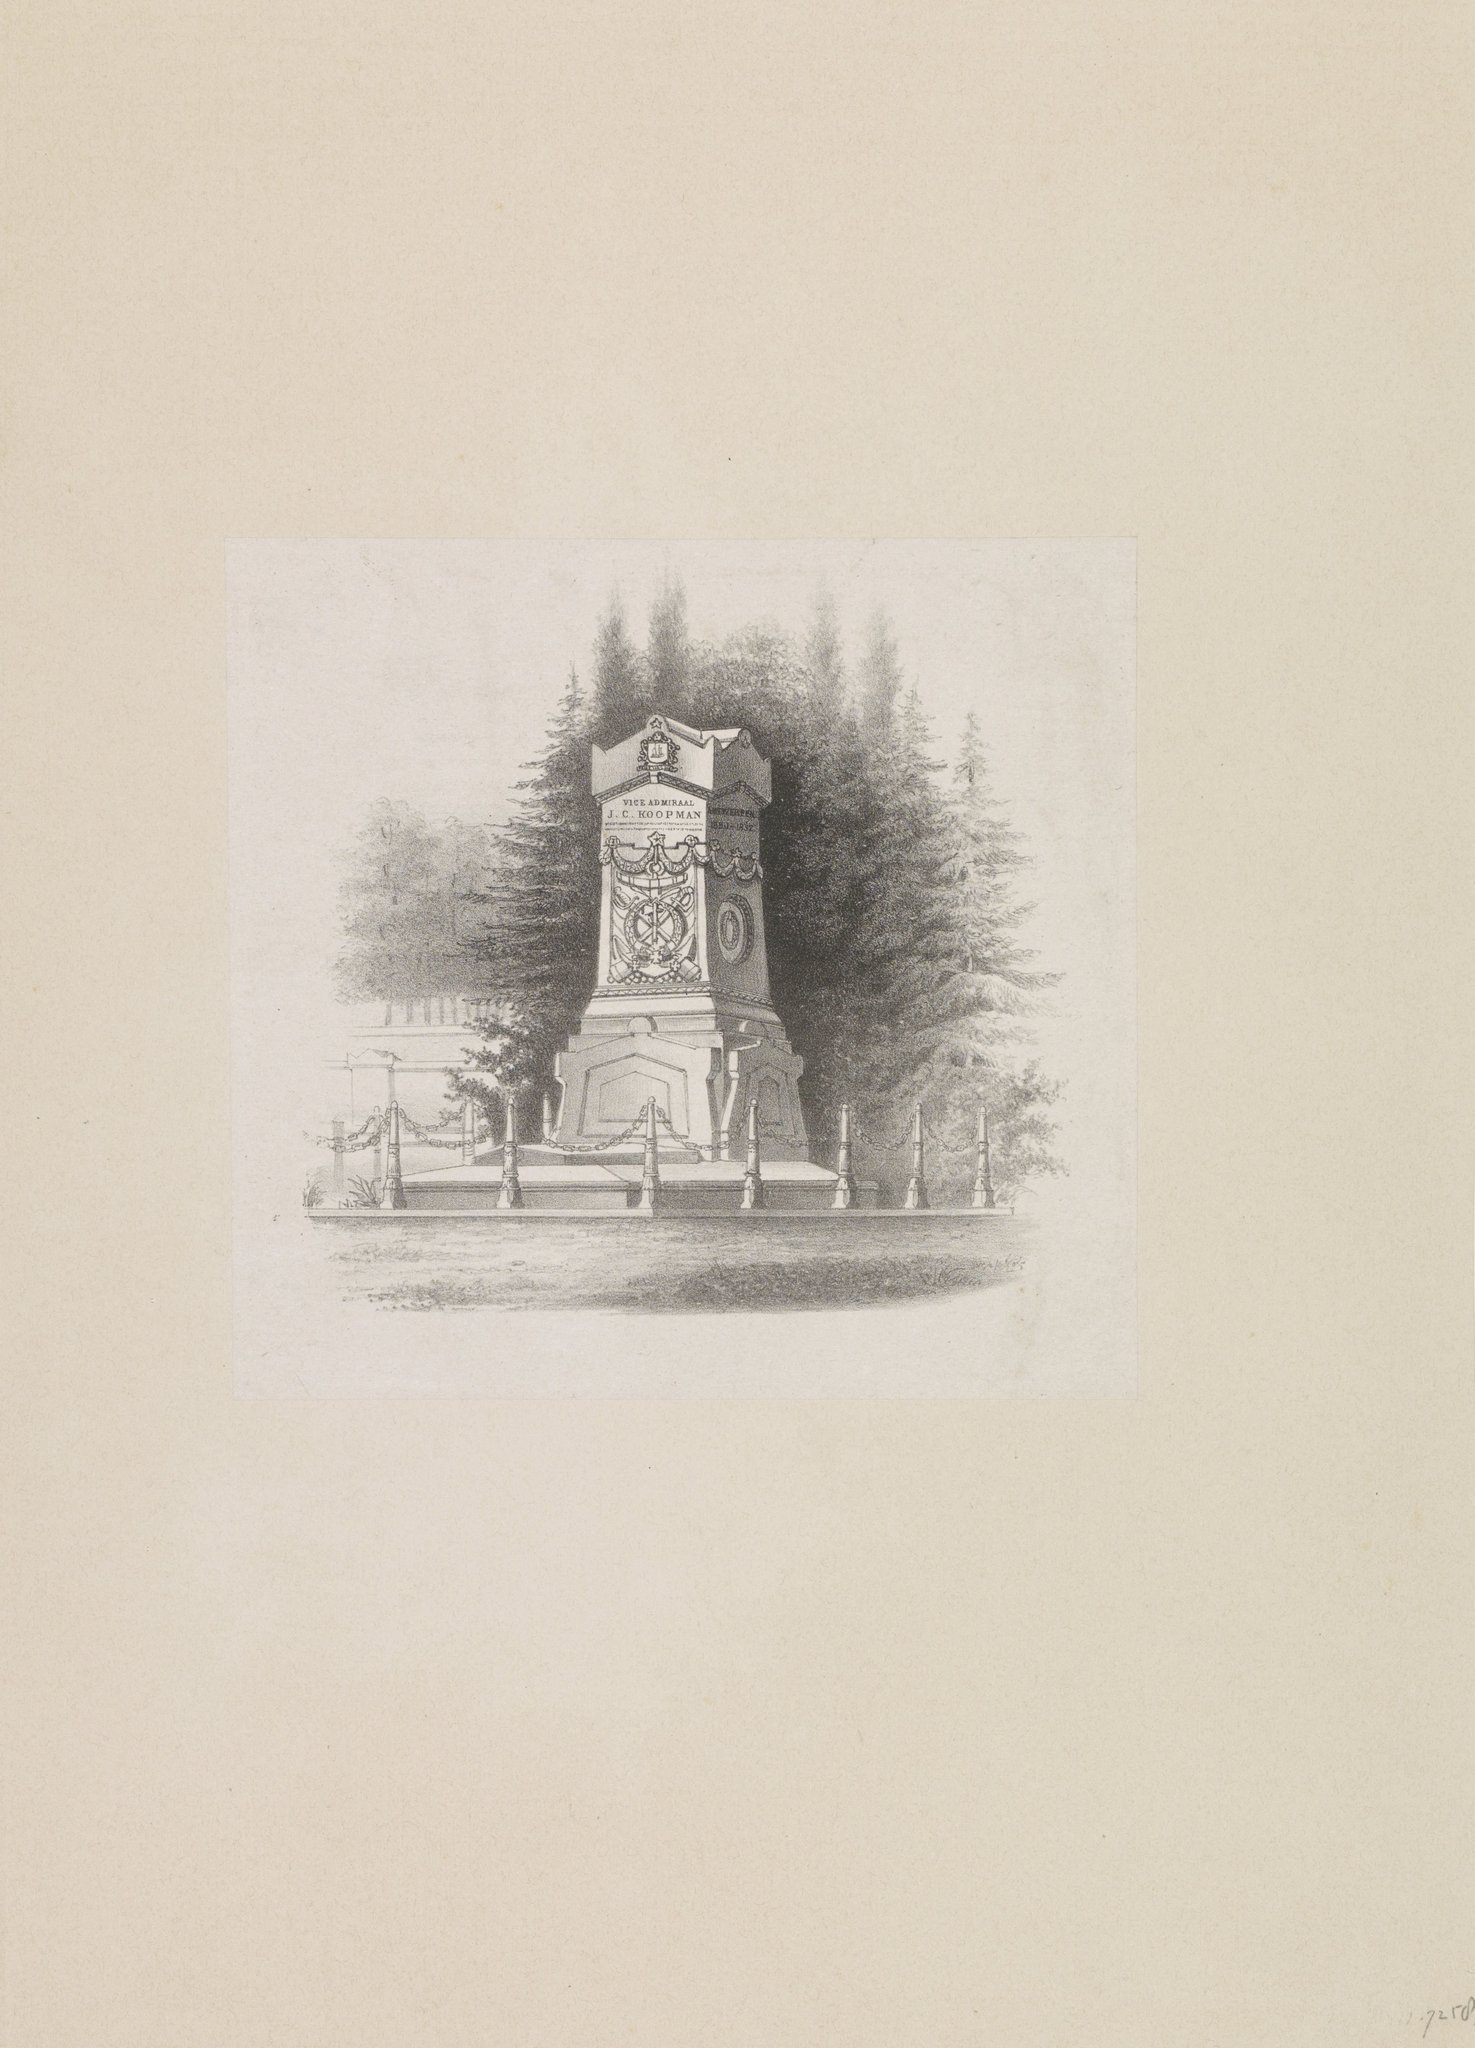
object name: print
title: Monument voor vice-admiraal J.C. Koopman, 1857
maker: Anonymous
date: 1857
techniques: printmaking, lithograph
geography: netherlands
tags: amsterdam, utrecht, grave-building, monumental tomb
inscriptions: collector's mark: Lugt 2228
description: Grafzuil voor vice-admiraal Jan Coenraad Koopman, overleden 21 april 1855, onthuld op de Begraafplaats Soestbergen te Utrecht op 20 maart 1857.